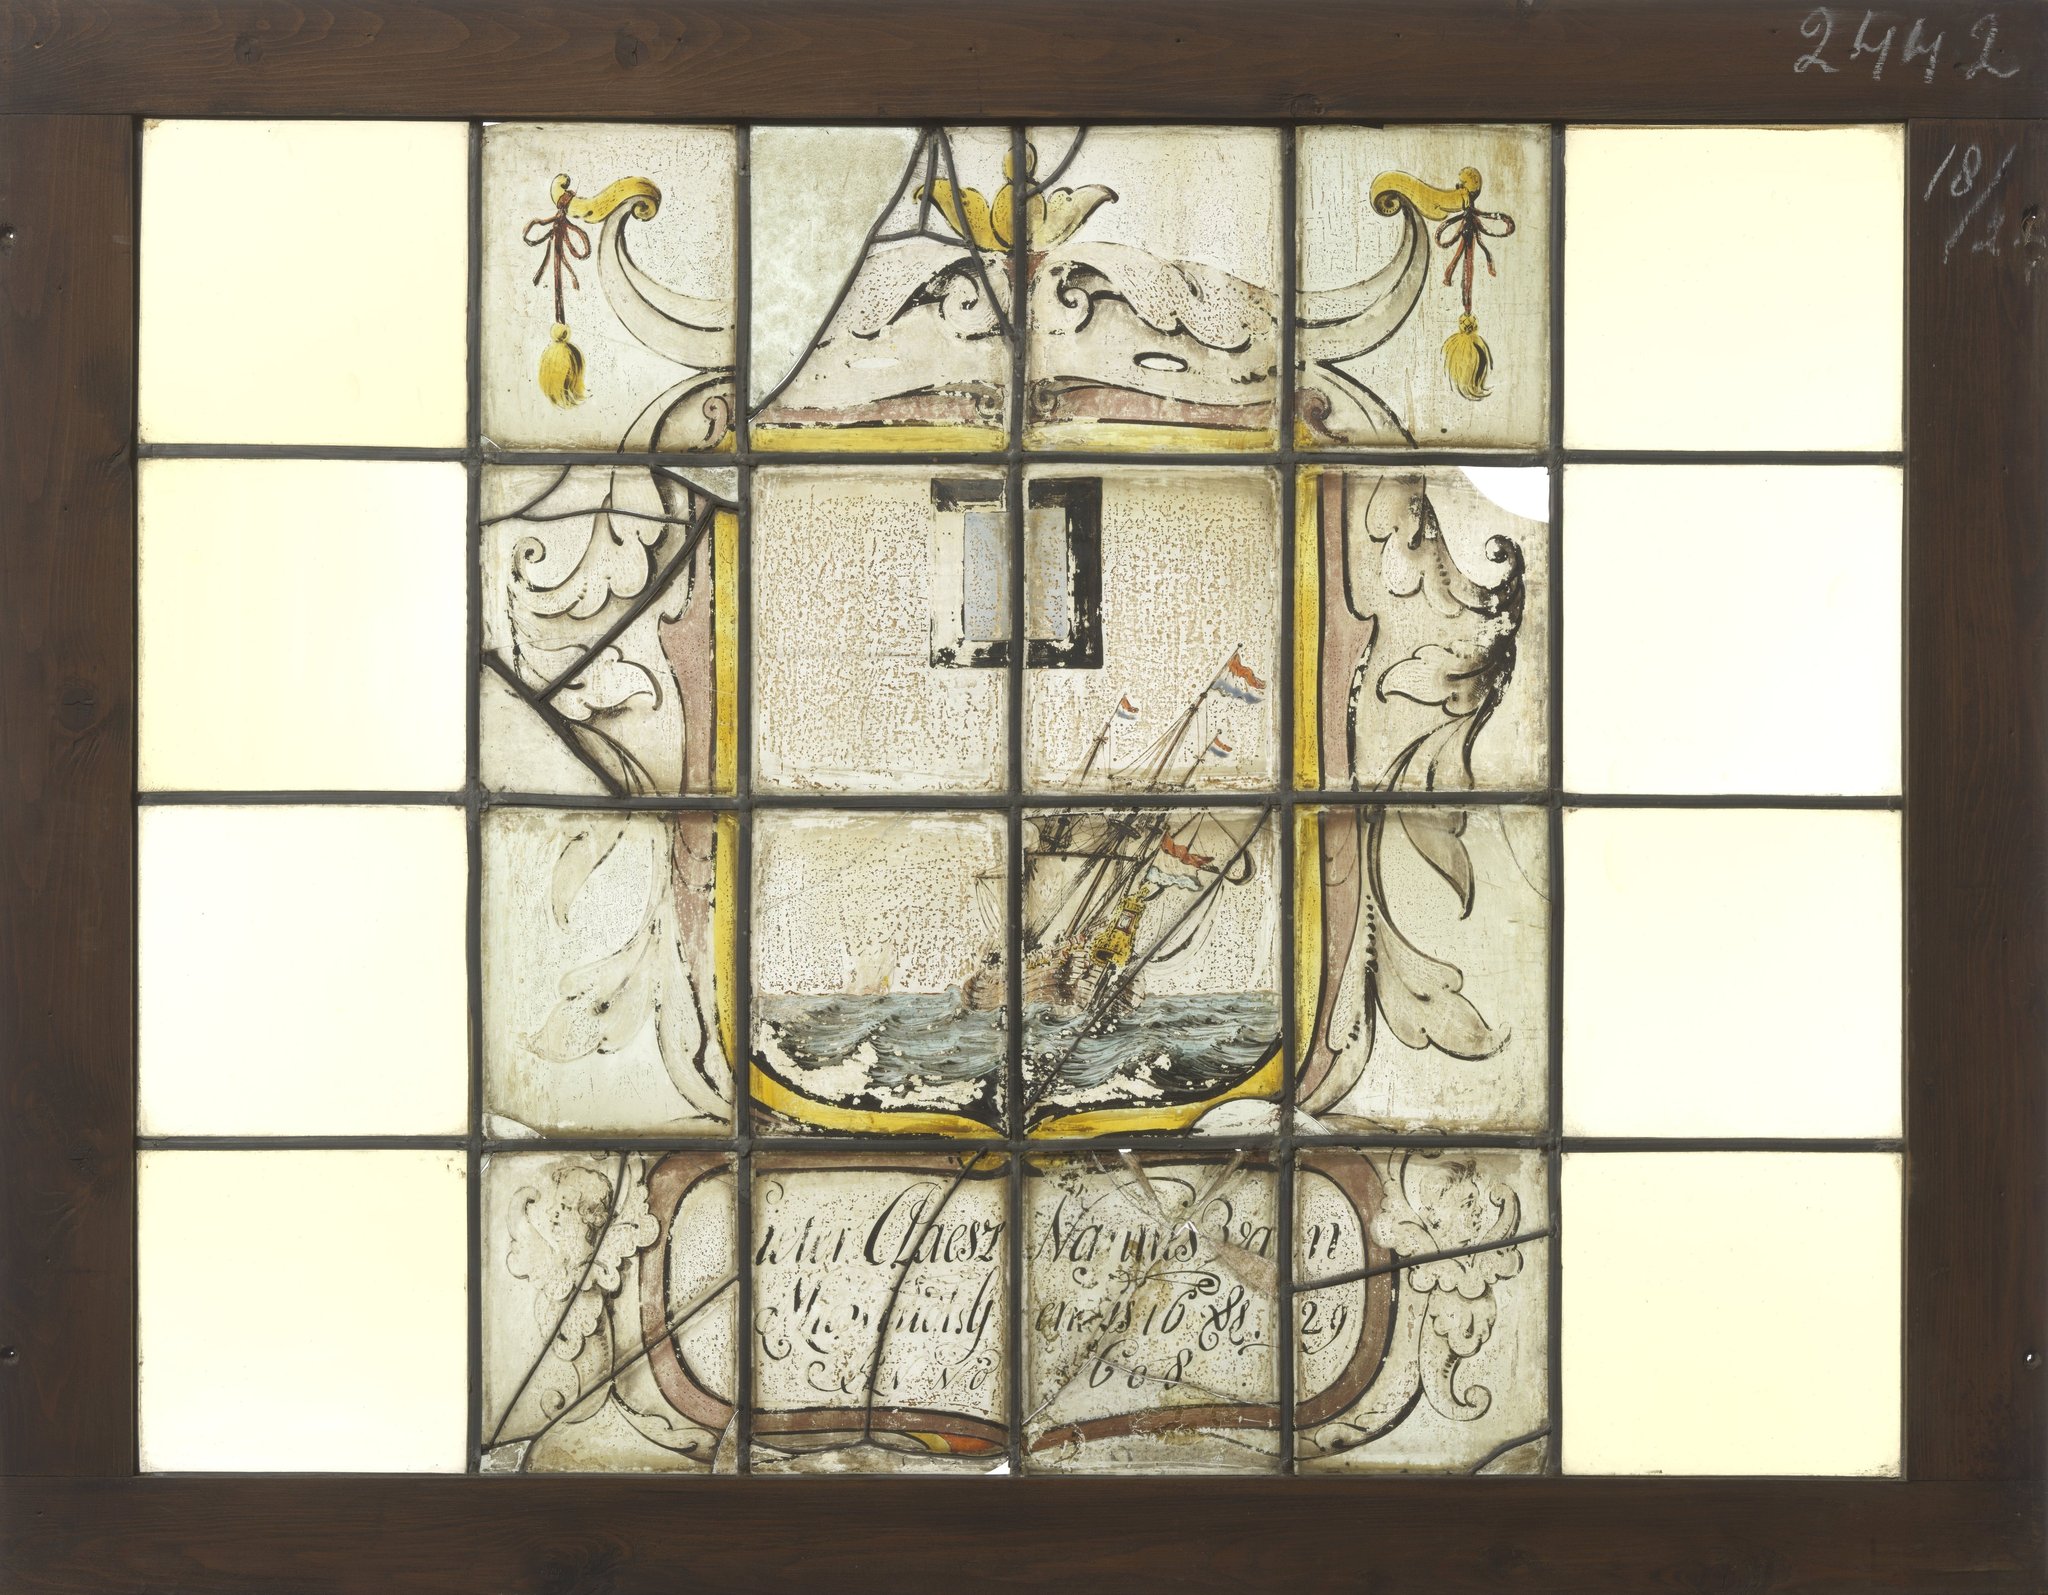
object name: light window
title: Ruit met in een wapenschild een marine voorstelling met onderschrift "Pieter Claesz Nannes van Midwout. Genesis 16 & 29 Anno 1608"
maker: Anonymous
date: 1608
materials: glass, lead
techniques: leading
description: Ruit met in een wapenschild een marine voorstelling met onderschrift "Pieter Claesz Nannes van Midwout. Genesis 16 & 29 Anno 1698".